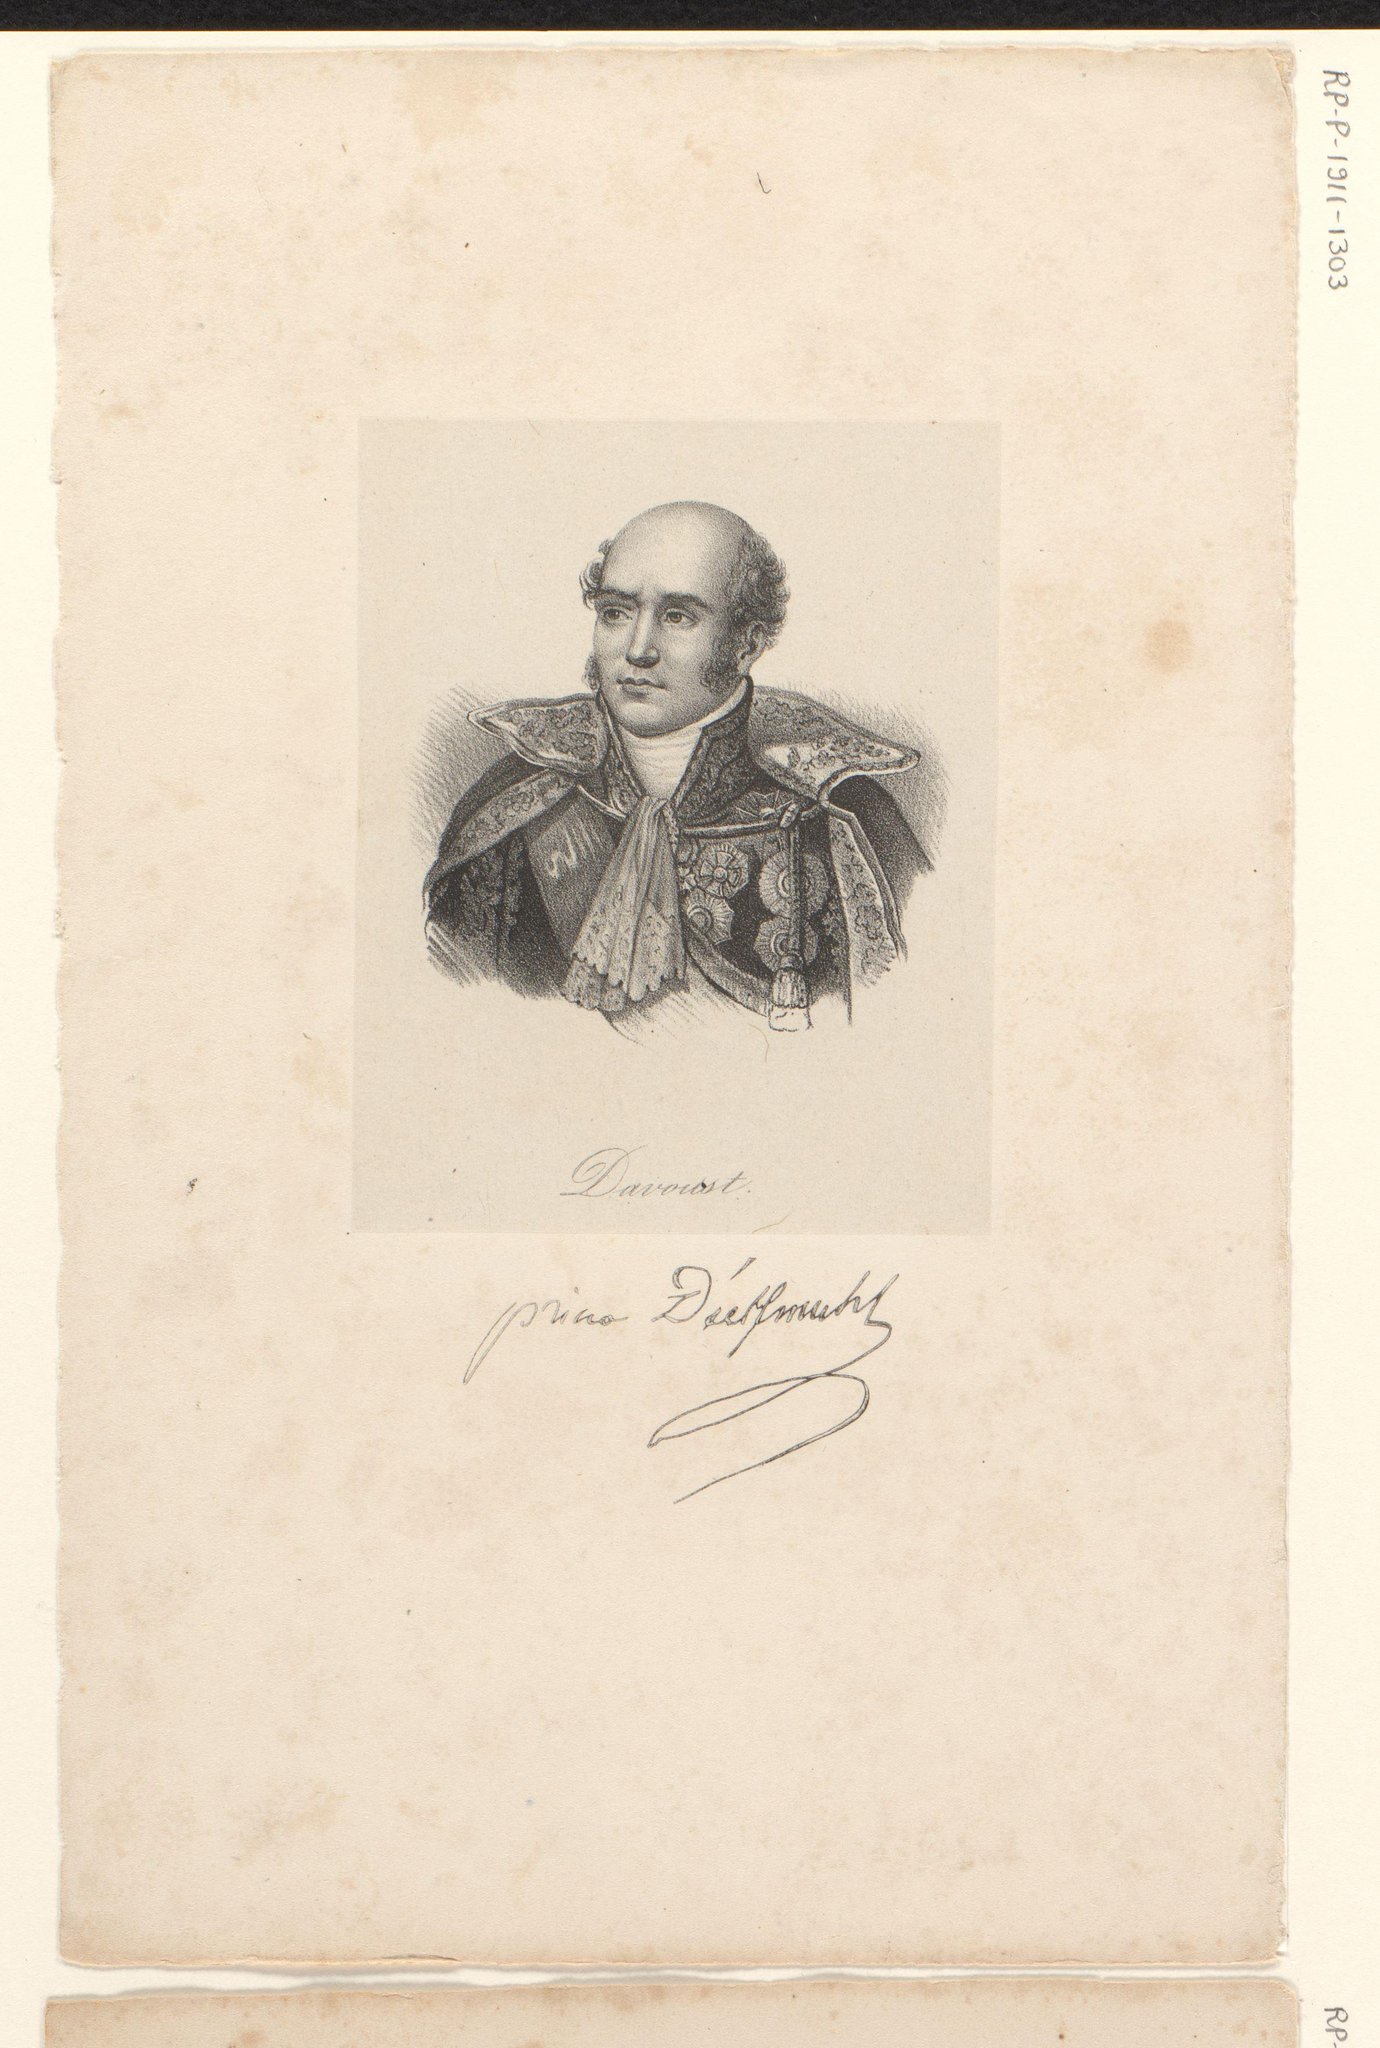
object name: print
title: Davoust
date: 1818-1842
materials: paper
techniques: lithograph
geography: paris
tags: historical persons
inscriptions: collector's mark: Lugt 2228a